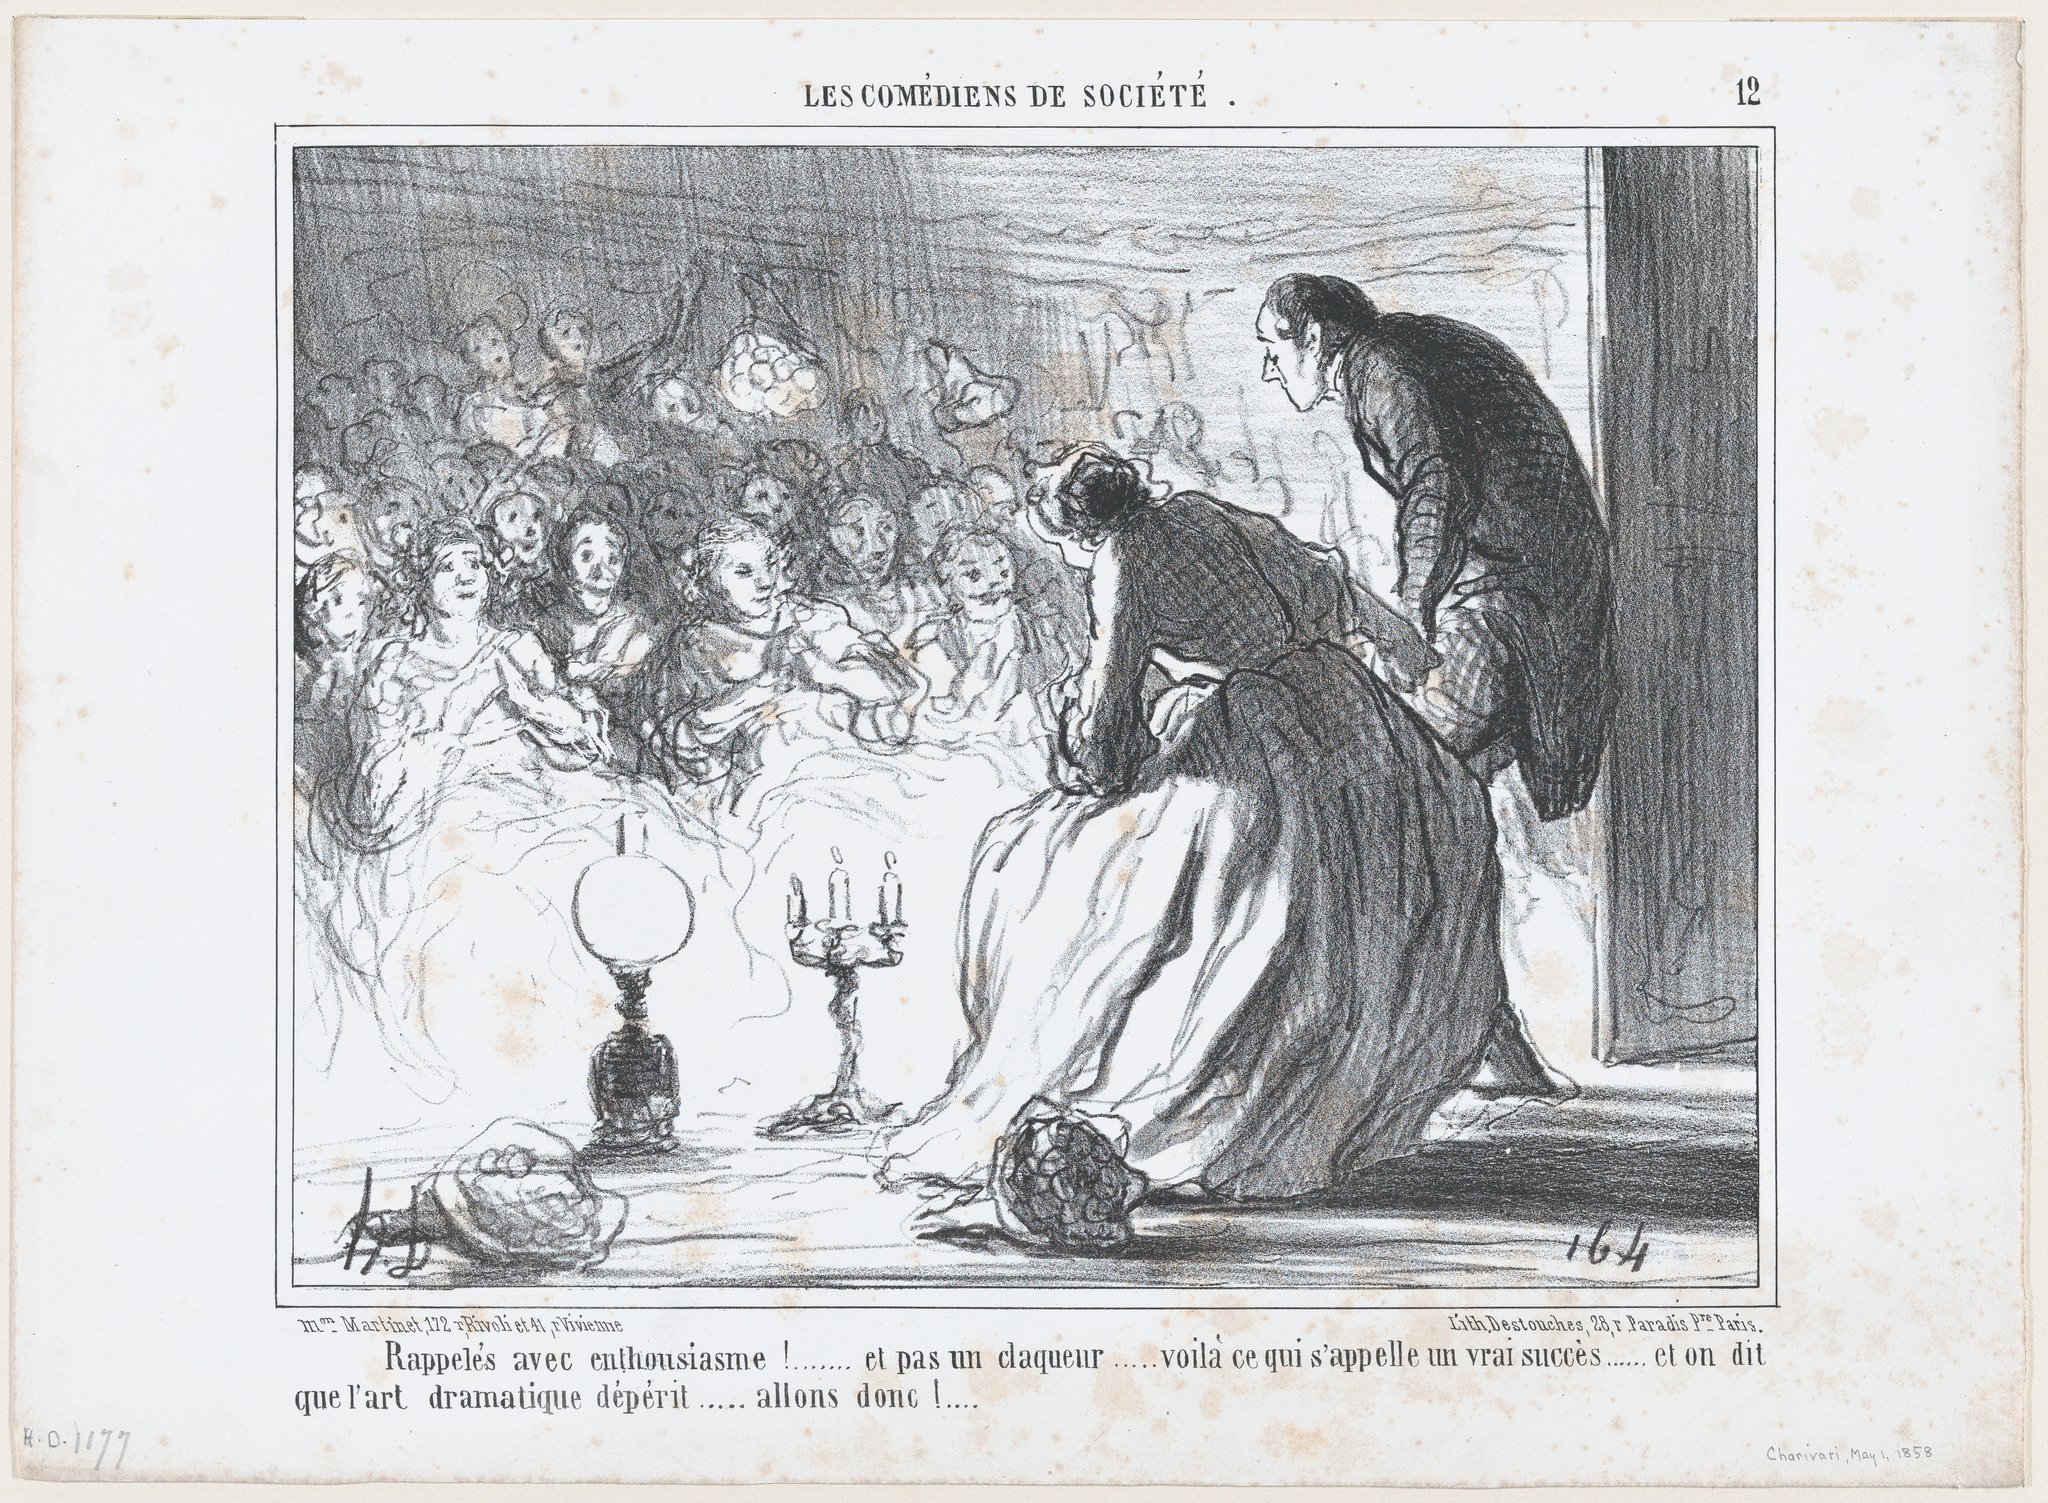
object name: print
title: Rappelés avec enthousiasme!.., from Les Comédiens de Société, published in "Le Charivari"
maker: honoré daumier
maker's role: artist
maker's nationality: french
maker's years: 1808-1879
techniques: lithograph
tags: performance,satire,theatre,men,women,spectators